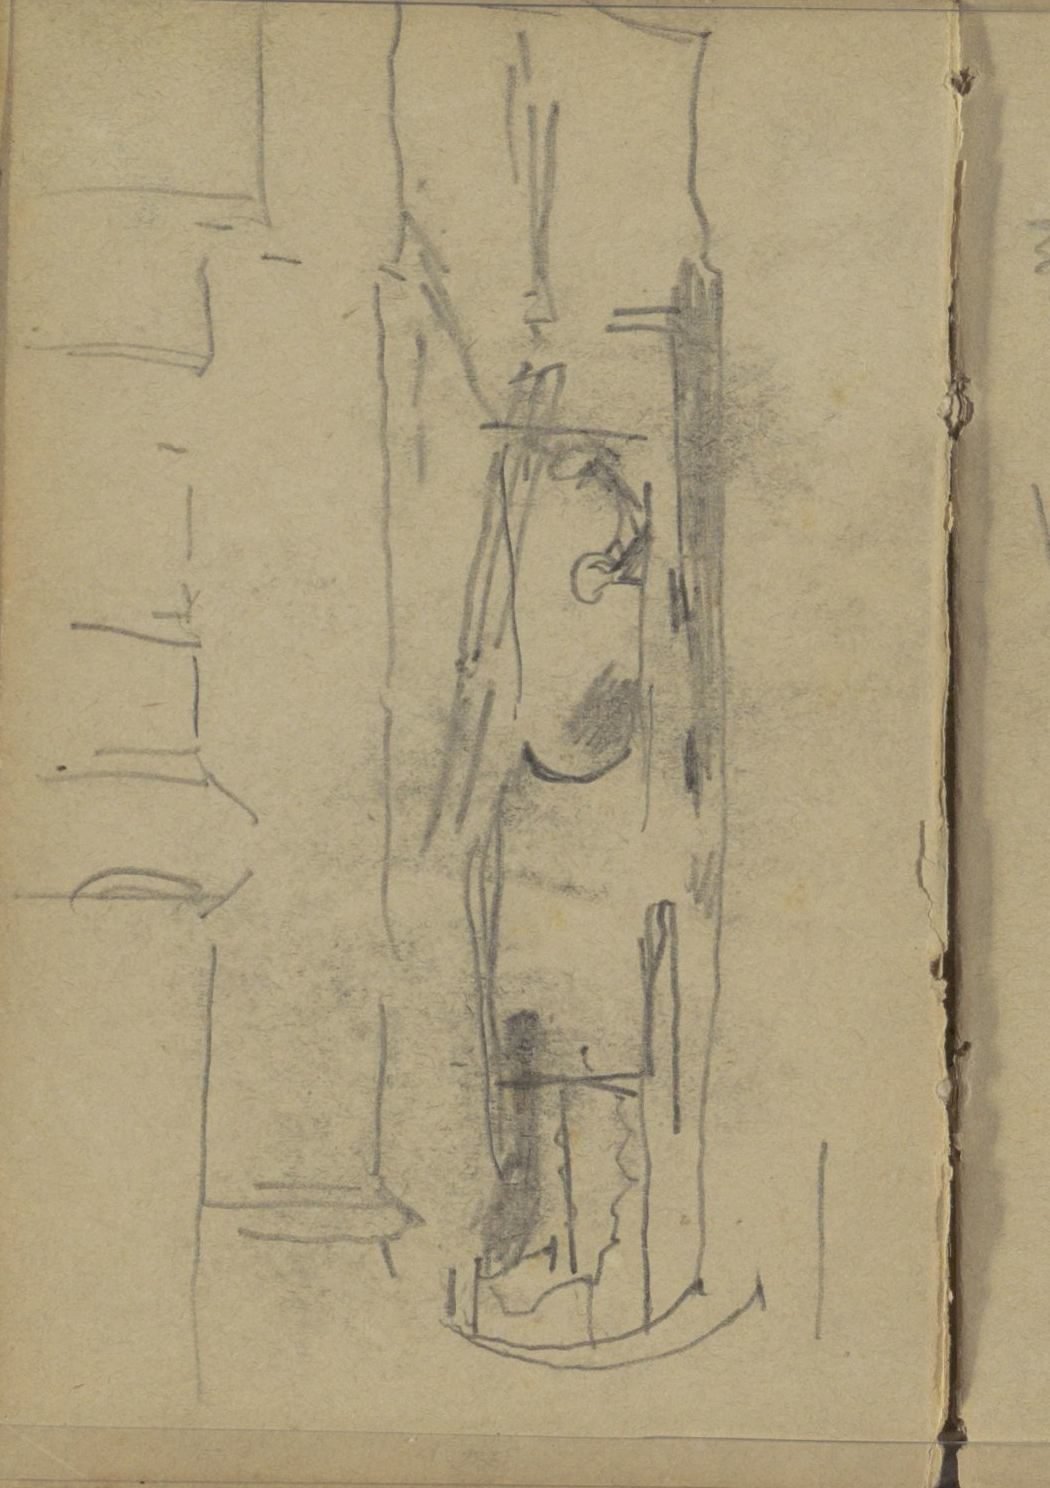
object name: sketchbook leaf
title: Vrouw in een steeg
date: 1887-1891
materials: paper, pencil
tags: adult woman, lane, alley (+ city(-scape) with figures, staffage)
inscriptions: workshop stamp: Lugt 291d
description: Pagina 109 uit een schetsboek met 83 bladen.